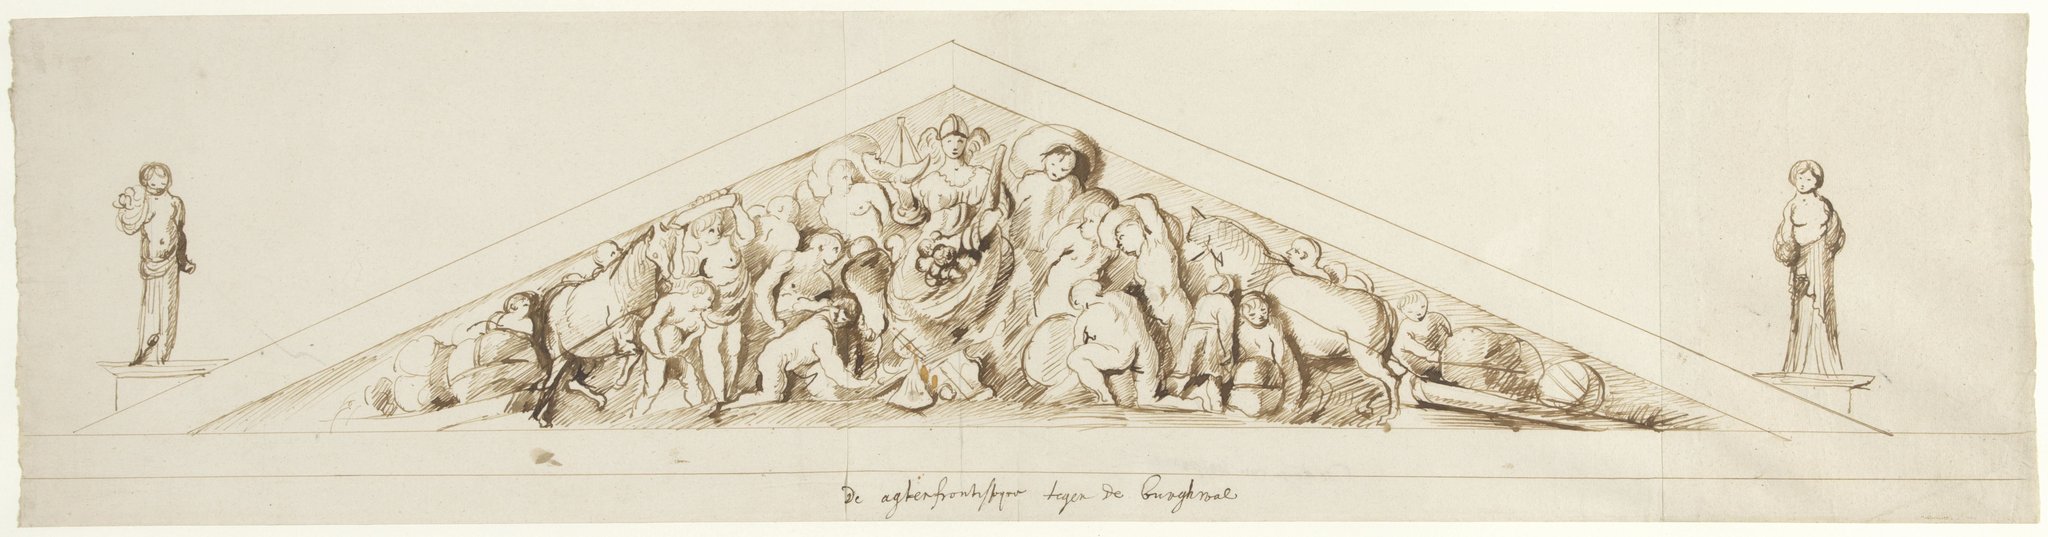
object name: drawing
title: Ontwerp voor het timpaan aan de westzijde van het Amsterdamse Stadhuis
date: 1646-1650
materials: ink, paper, pencil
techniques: pen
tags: piece of sculpture, reproduction of a piece of sculpture, cities represented allegorically or symbolically, architectural design or model, allegory of trade; 'commertio della vita humana' (ripa), amsterdam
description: Ontwerp voor de beeldengroep in het timpaan aan de westzijde van het Amsterdamse Stadhuis.